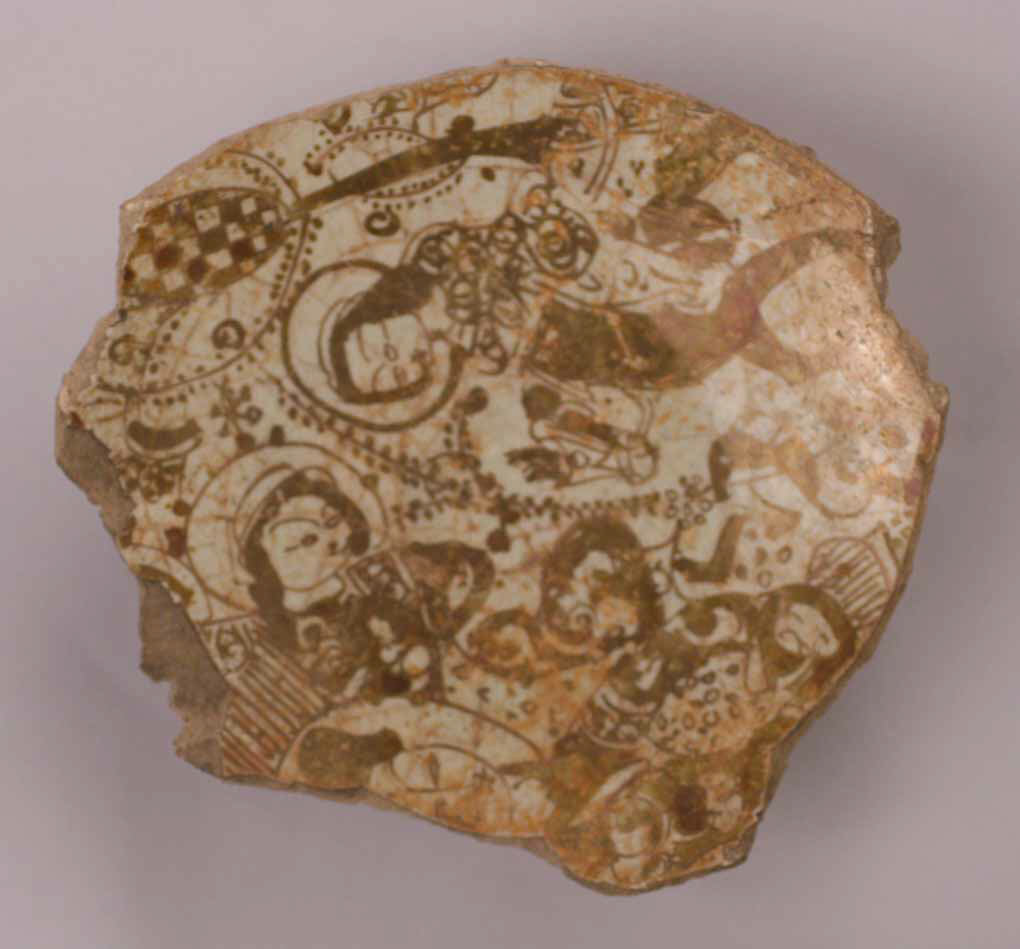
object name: fragment of a bowl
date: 1201-1300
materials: stonepaste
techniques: glazing, luster painting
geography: iran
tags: human figures